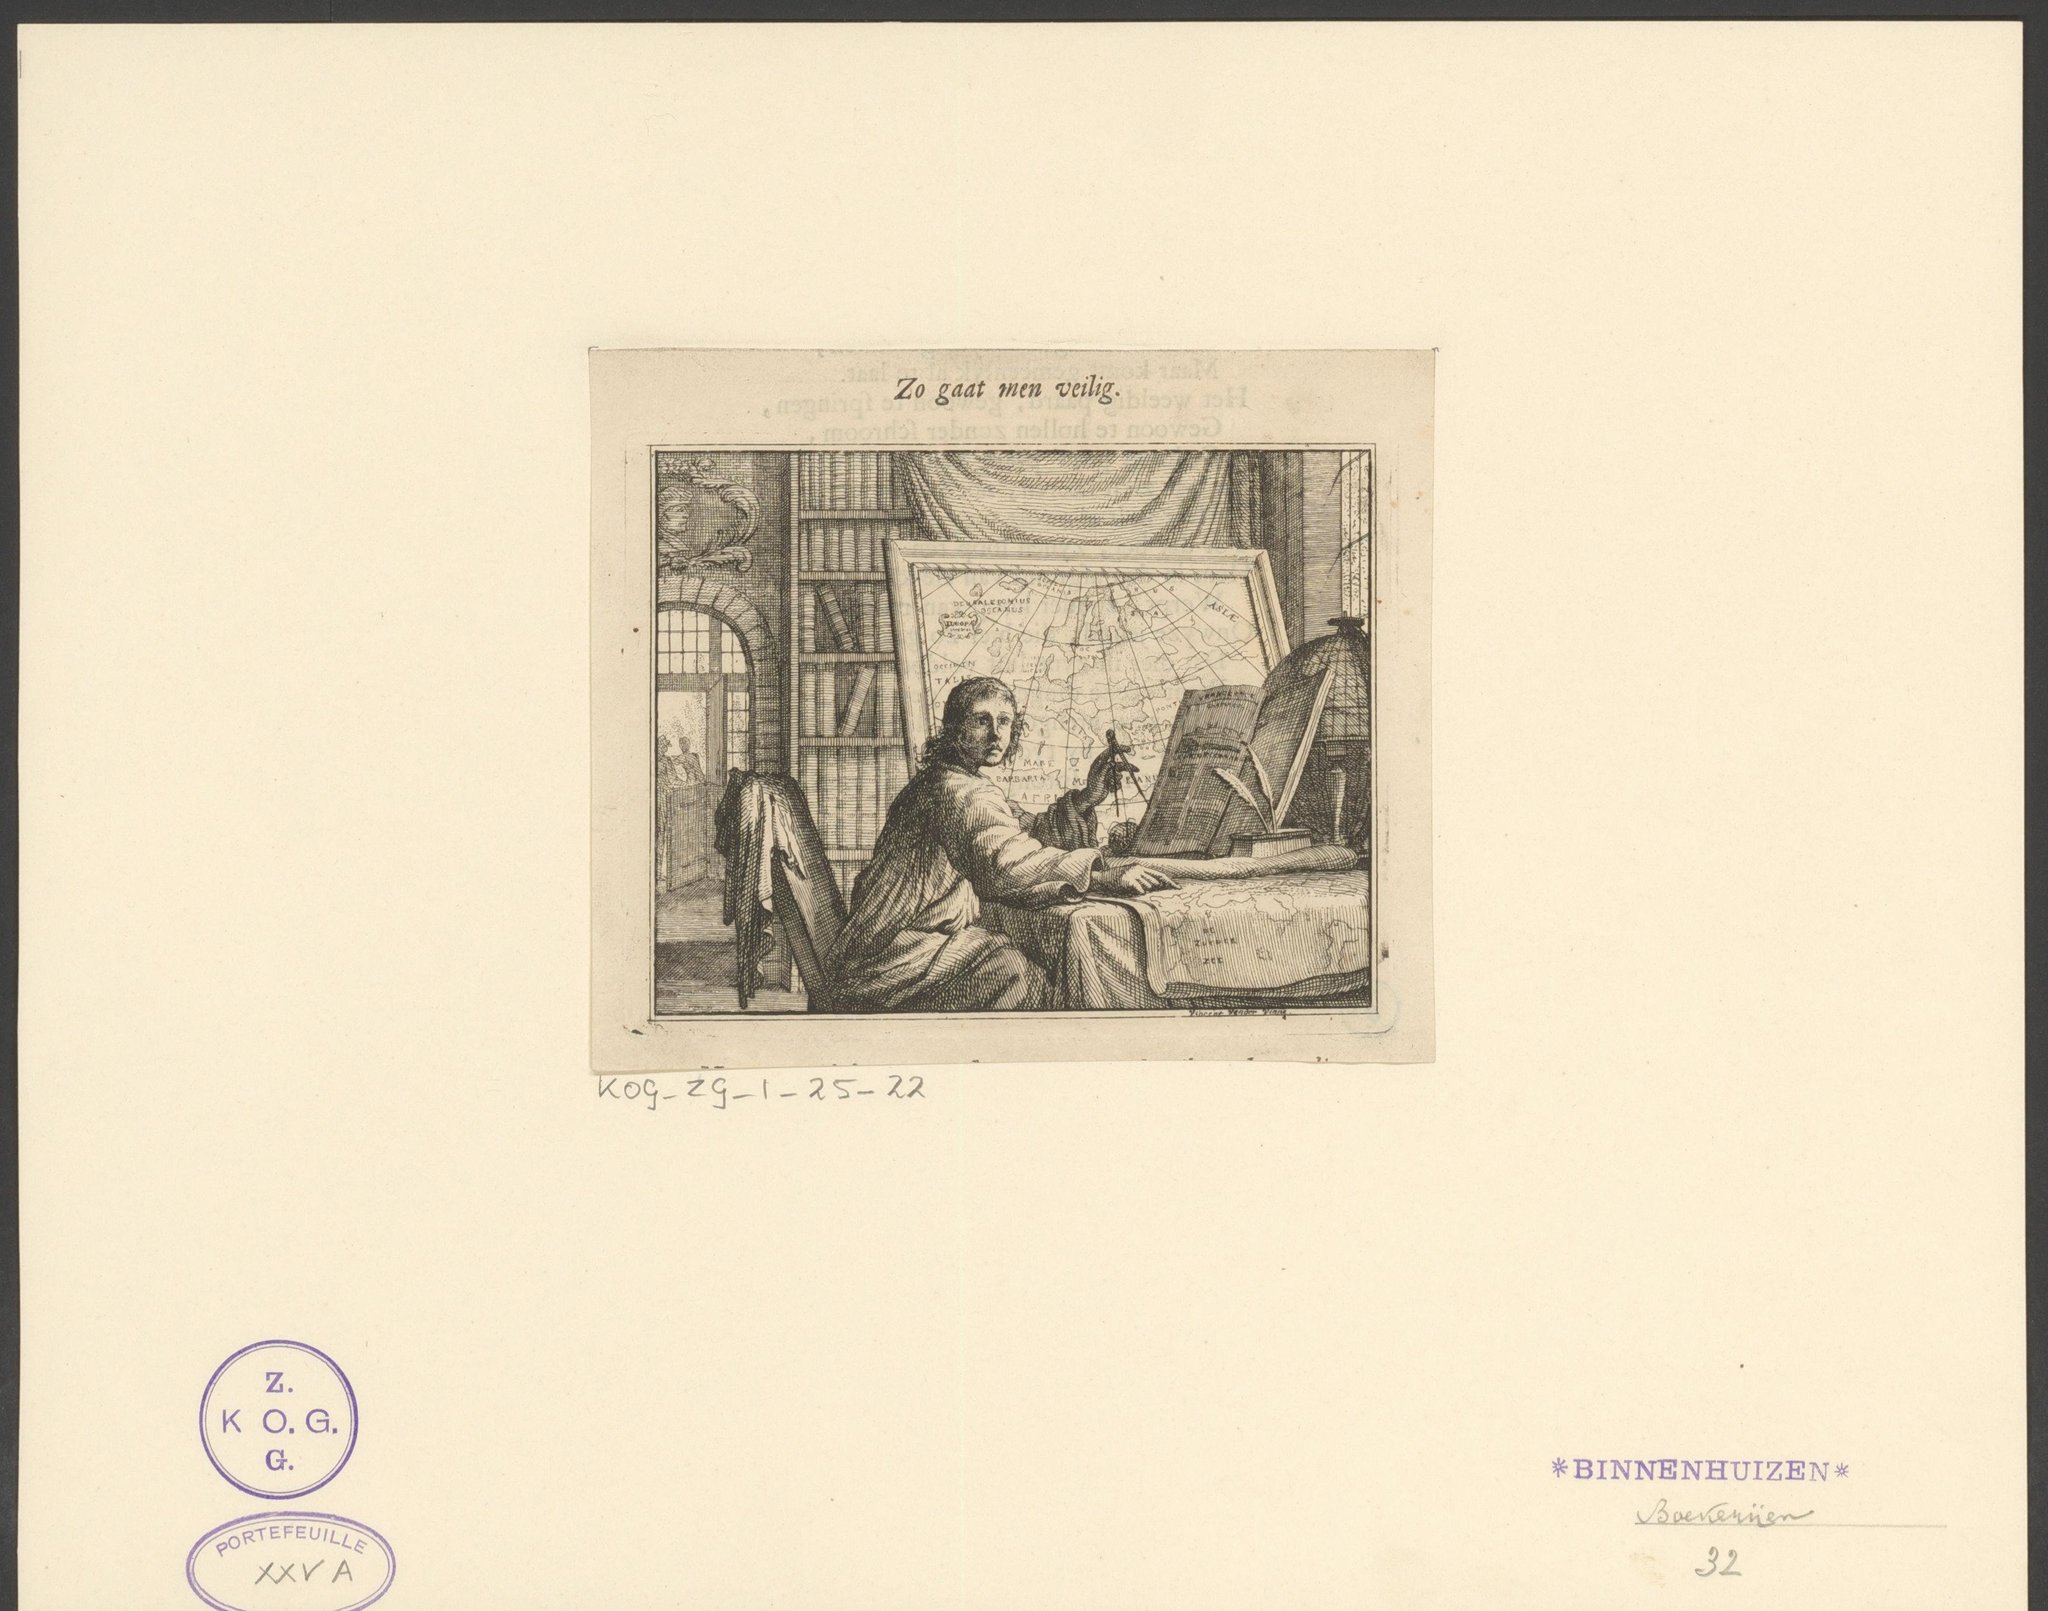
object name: print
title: Cartograaf aan het werk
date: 1714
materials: paper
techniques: etching, letterpress printing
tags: scholar in his study, map of the world, book - mm - book open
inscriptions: stamp, collector's mark: Lugt 1641, stamp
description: Onderwerpsrubrieken binnen de Atlas Zeden en Gewoonten: Zeden en Gewoonten in Engeren Zin, De Woning, Binnenhuizen, Boekerijen.